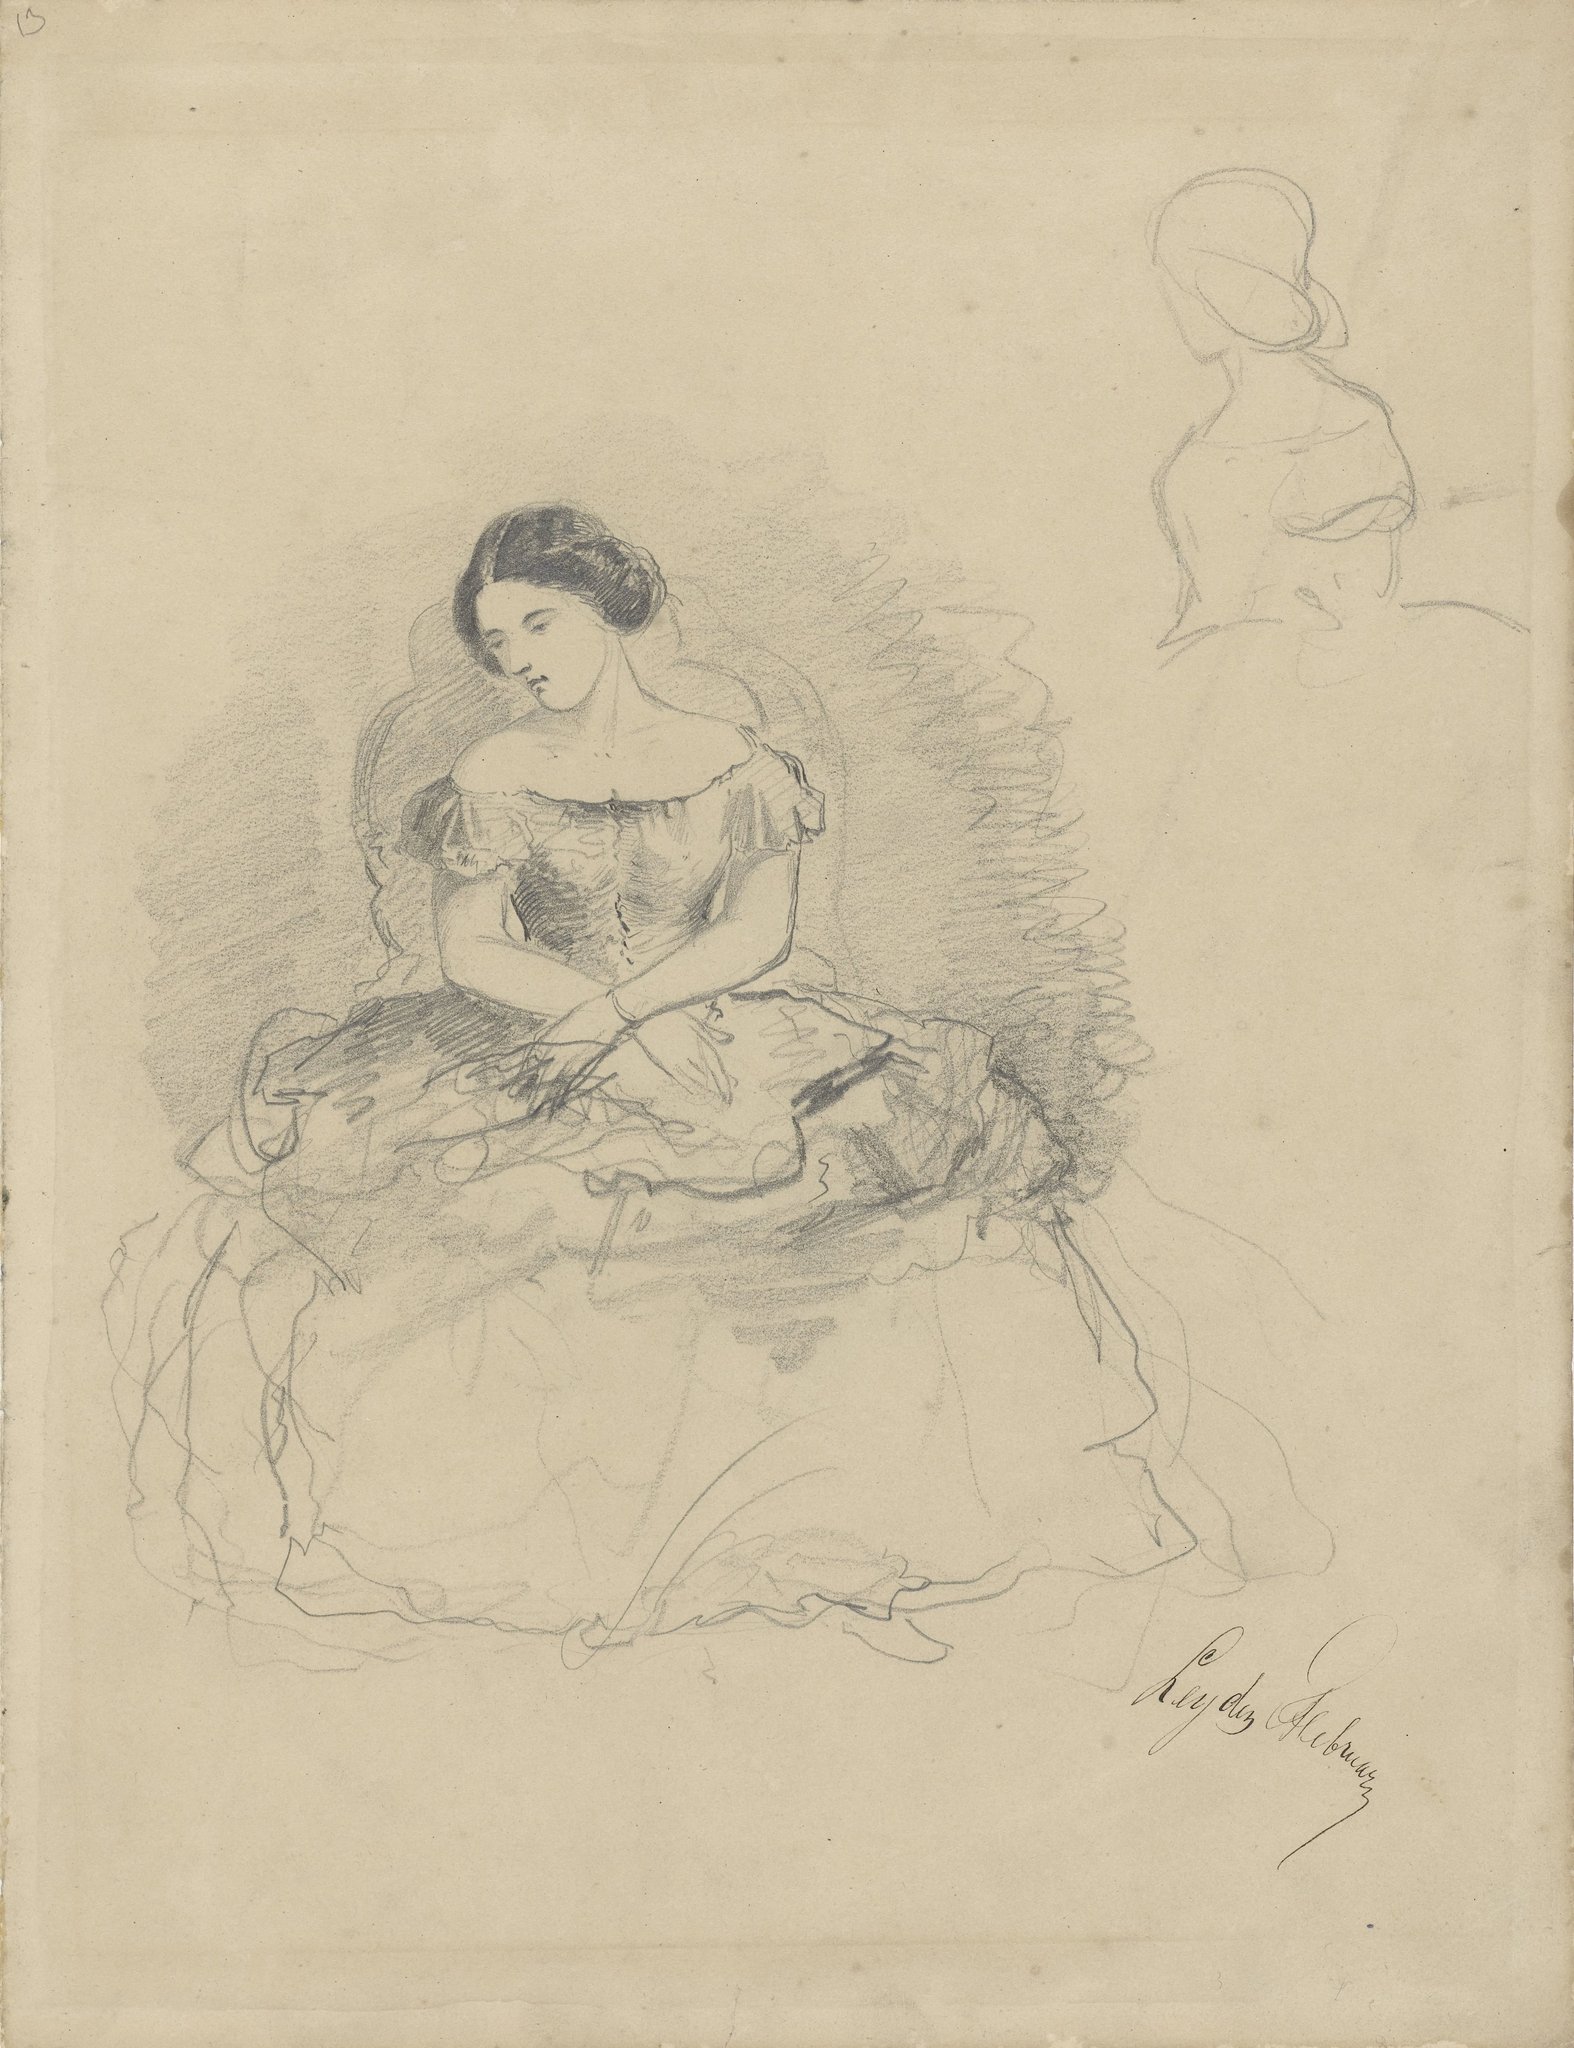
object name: drawing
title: Zittende dame, in avondtoilet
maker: gerard bilders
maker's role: draughtsman, print maker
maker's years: 1838-1865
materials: paper, pencil